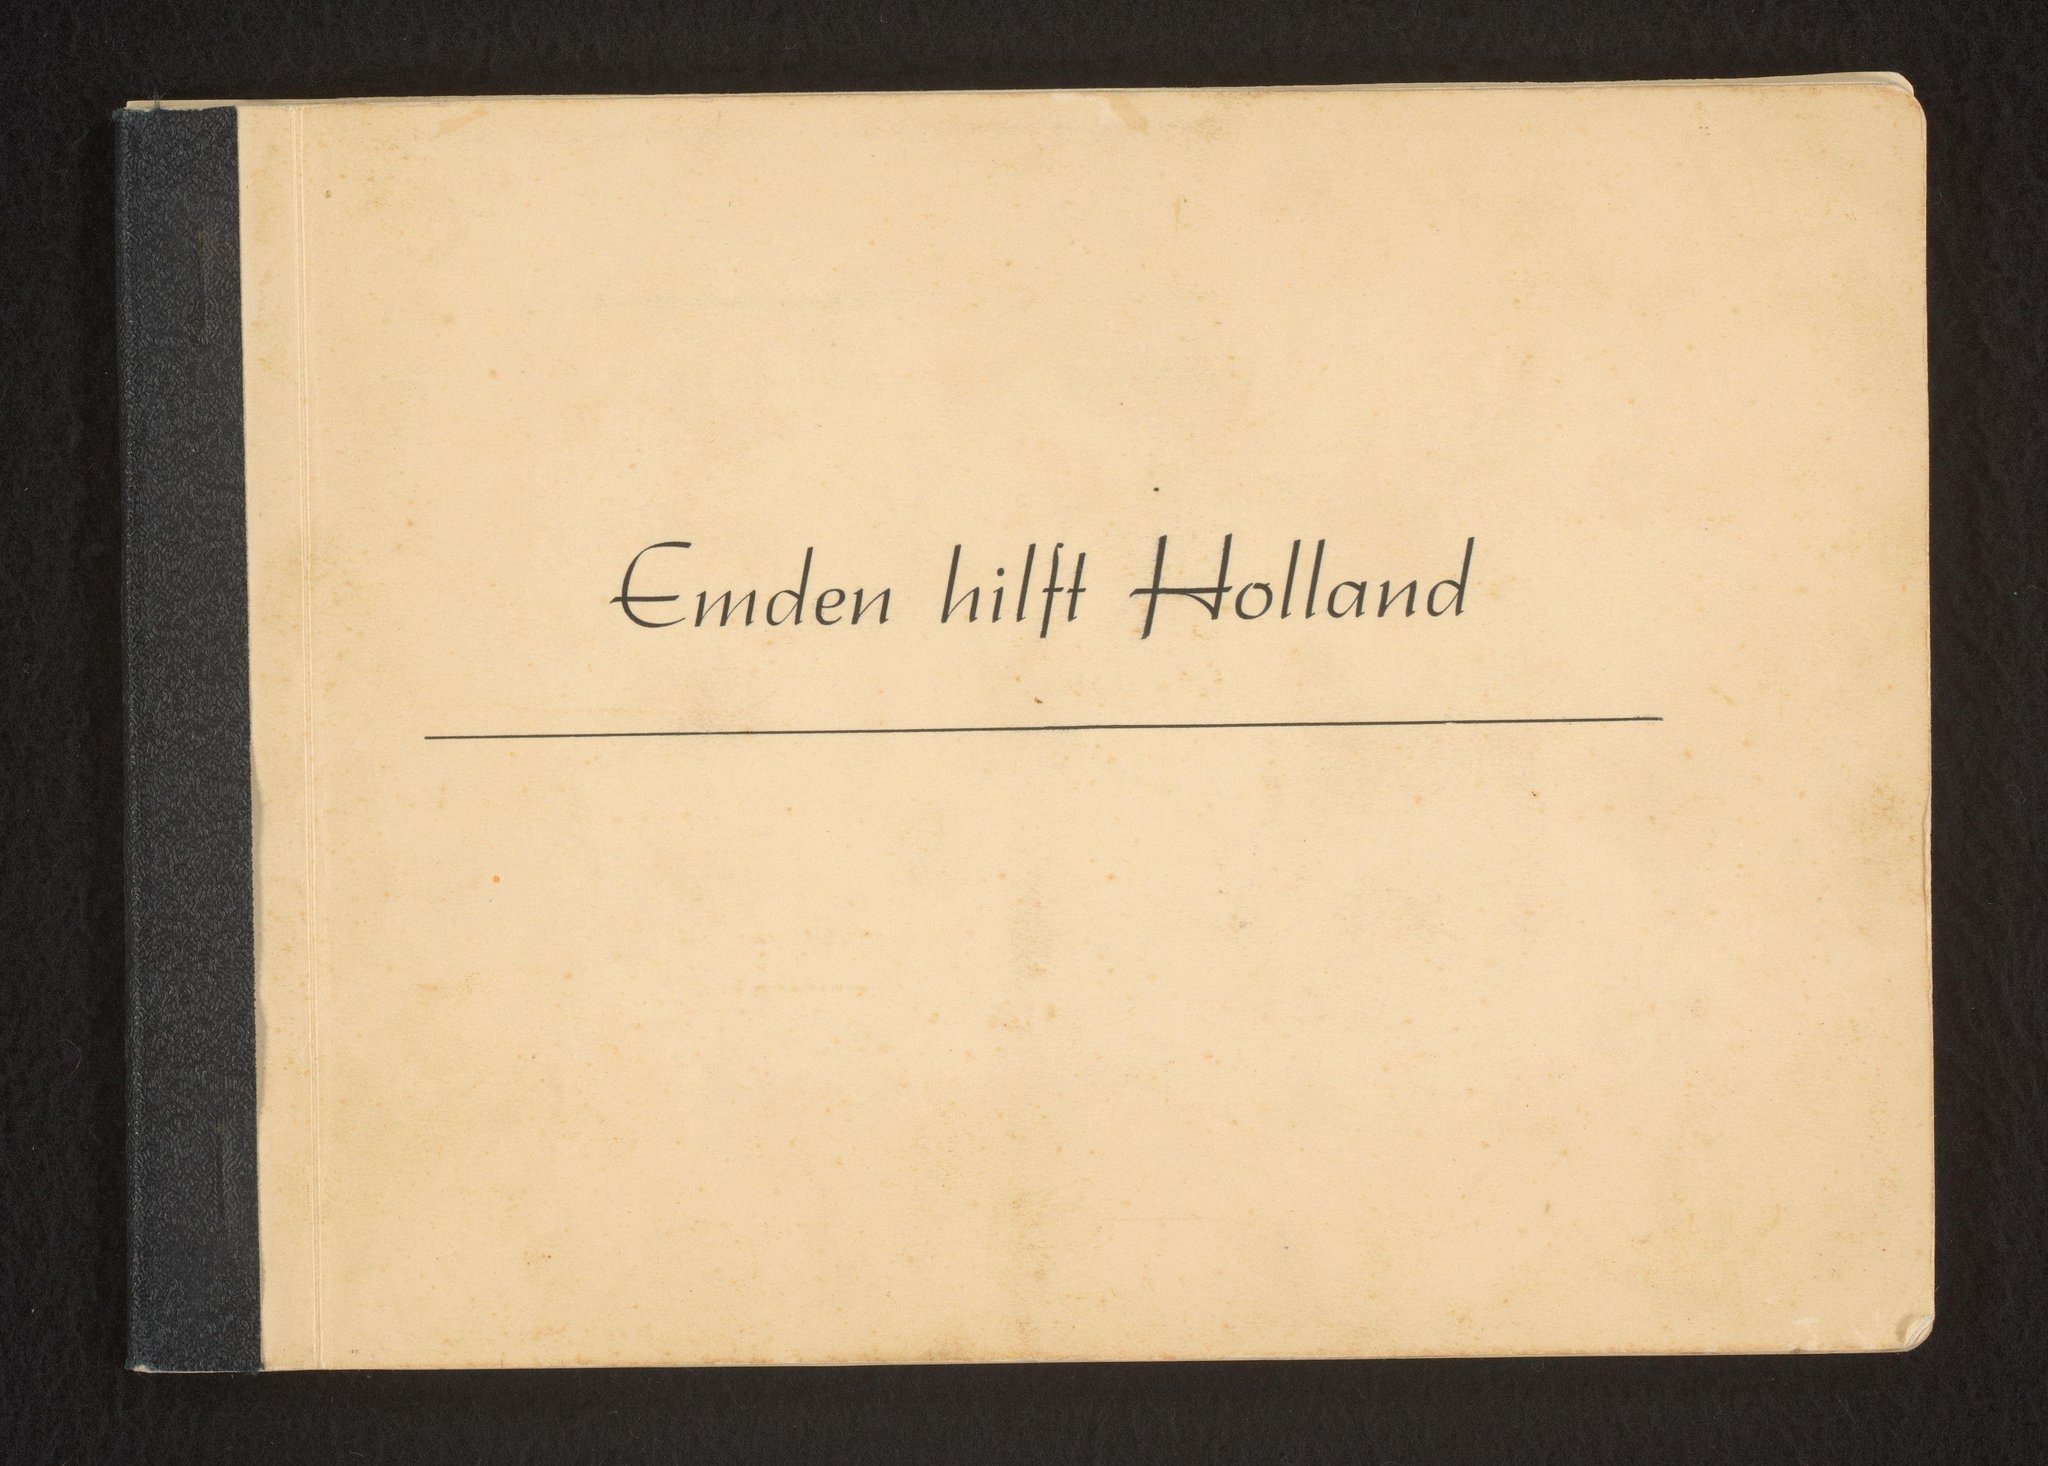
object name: photograph album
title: Emden hilft Holland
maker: Anonymous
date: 1902-1953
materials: paper, photographic support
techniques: gelatin silver print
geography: emden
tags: netherlands, north sea flood of 1953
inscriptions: date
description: Fotoalbum met de titel 'Emden hilft Holland', met foto's van de bouw van 38 boten als noodhulp voor het door de watersnood van 1953 getroffen Nederland. Op de titelpagina staat 'Nordseewerke Emden GMBH bauen 38 Hilfsboote für die Hochwasserkatastrophe in Holland. Februar 1953'. Het boekje bevat een titelpagina en 12 pagina's met 17 foto's. De foto's tonen de fabricage en het transport van de metalen sloepen.